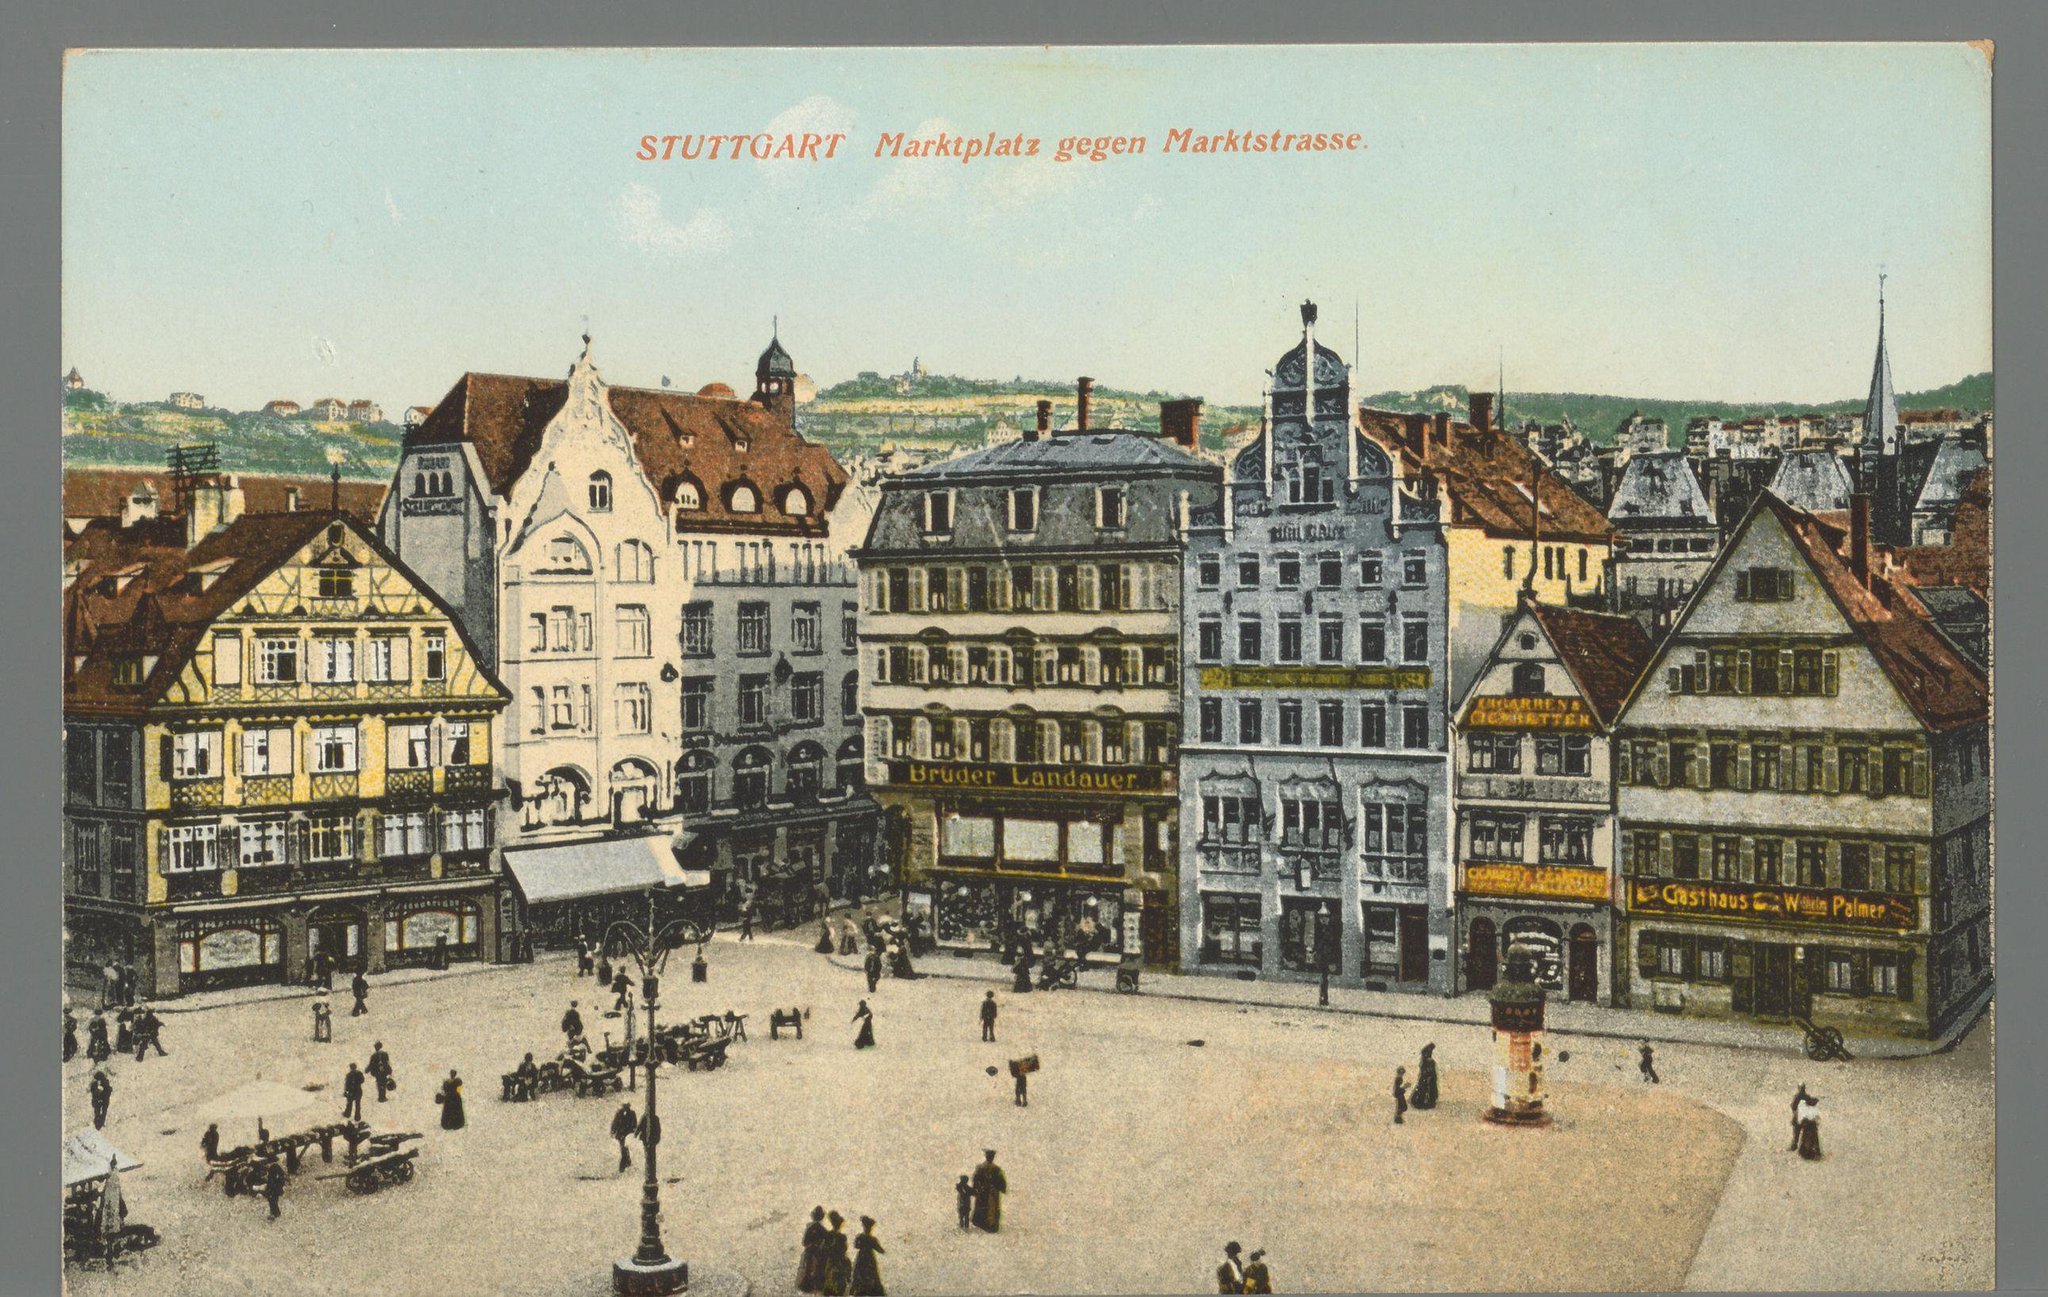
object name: ansichtkaart, prentbriefkaart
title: Stuttgart. Marktplatz gegen Marktstrasse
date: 1905-1909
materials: cardboard, photographic process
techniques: writing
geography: stuttgart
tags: square, place, circus, etc., market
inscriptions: monogram: ‘Photochrom M.S. P.’